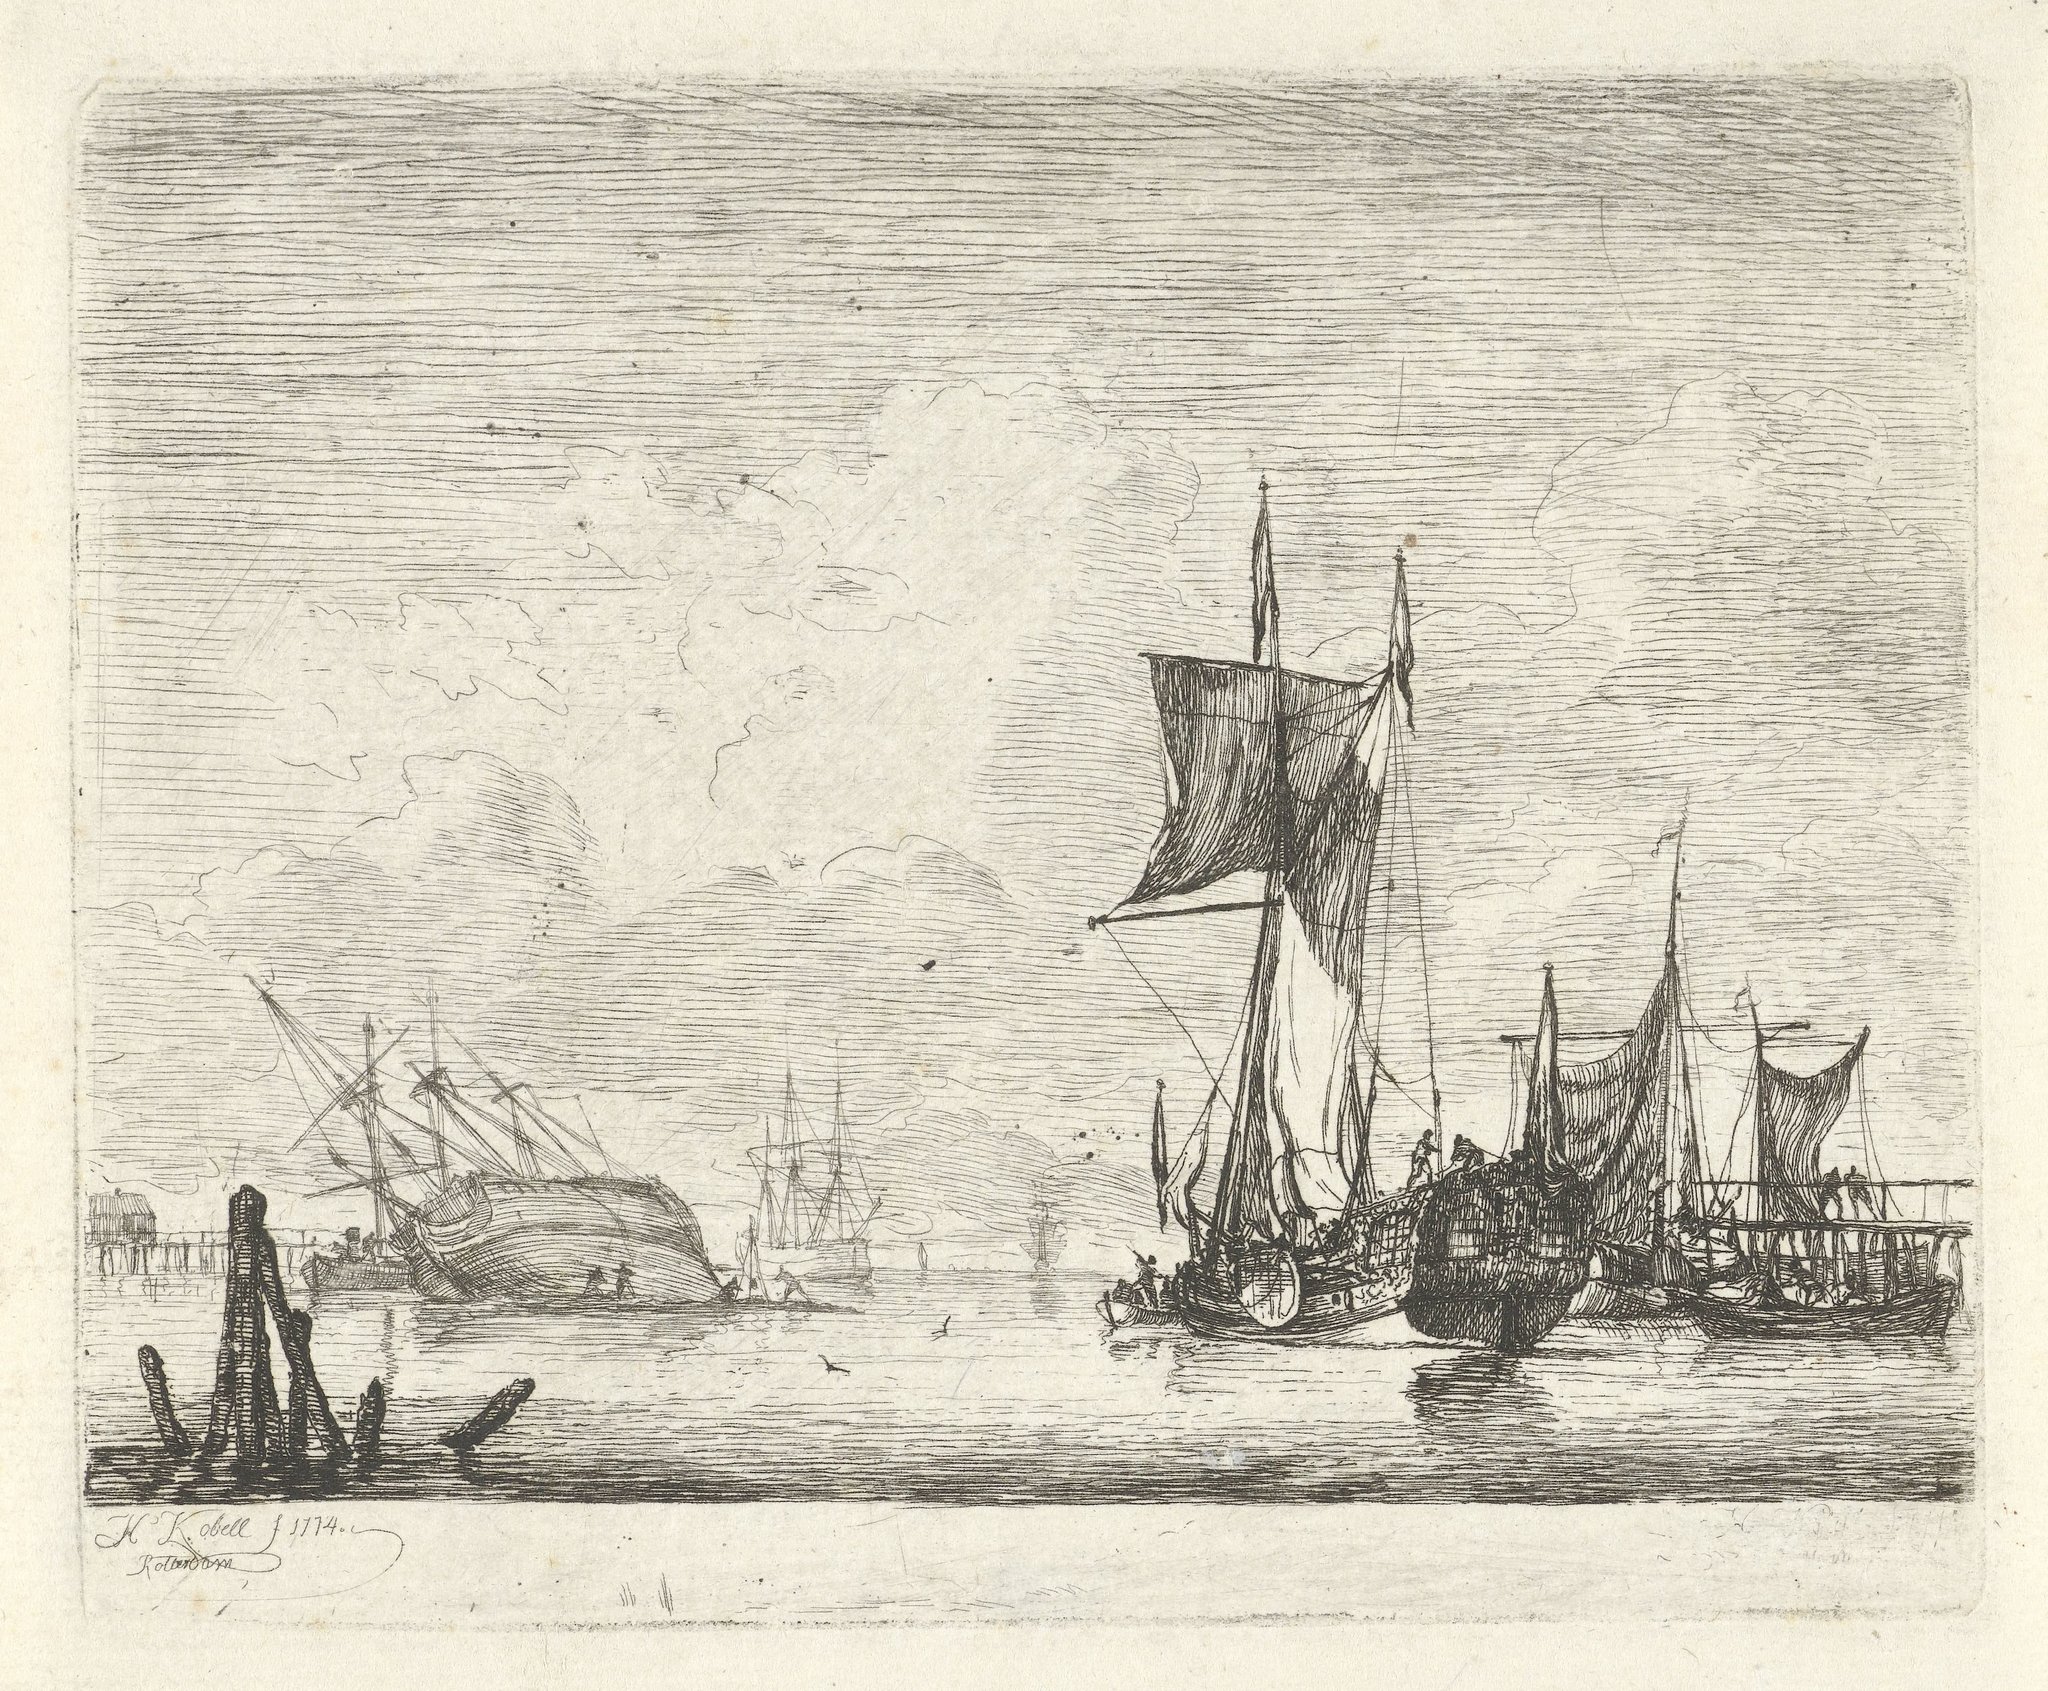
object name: print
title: Riviergezicht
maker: hendrik kobell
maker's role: draughtsman, painter, print maker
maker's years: 1751-1779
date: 1774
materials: paper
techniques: etching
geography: rotterdam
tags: sailing-ship, sailing-boat, river, pier, quay, wharf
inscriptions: collector's mark: Lugt 2227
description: Riviergezicht met verschillende schepen, waarvan er één drooggevallen is. Bij het drooggevallen schip bevinden zich vier figuren en op de achtergrond is een steiger met daarop een huisje te zien.